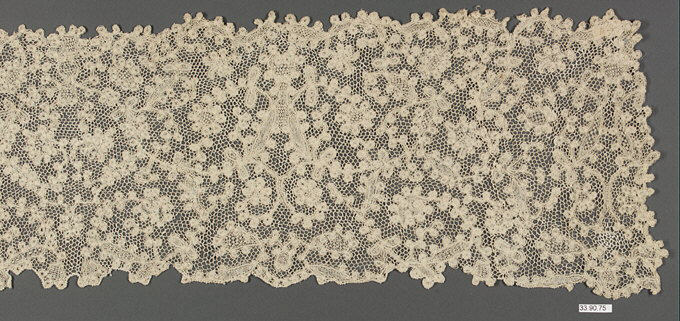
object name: scarf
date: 1701-1733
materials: lace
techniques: lace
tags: flowers